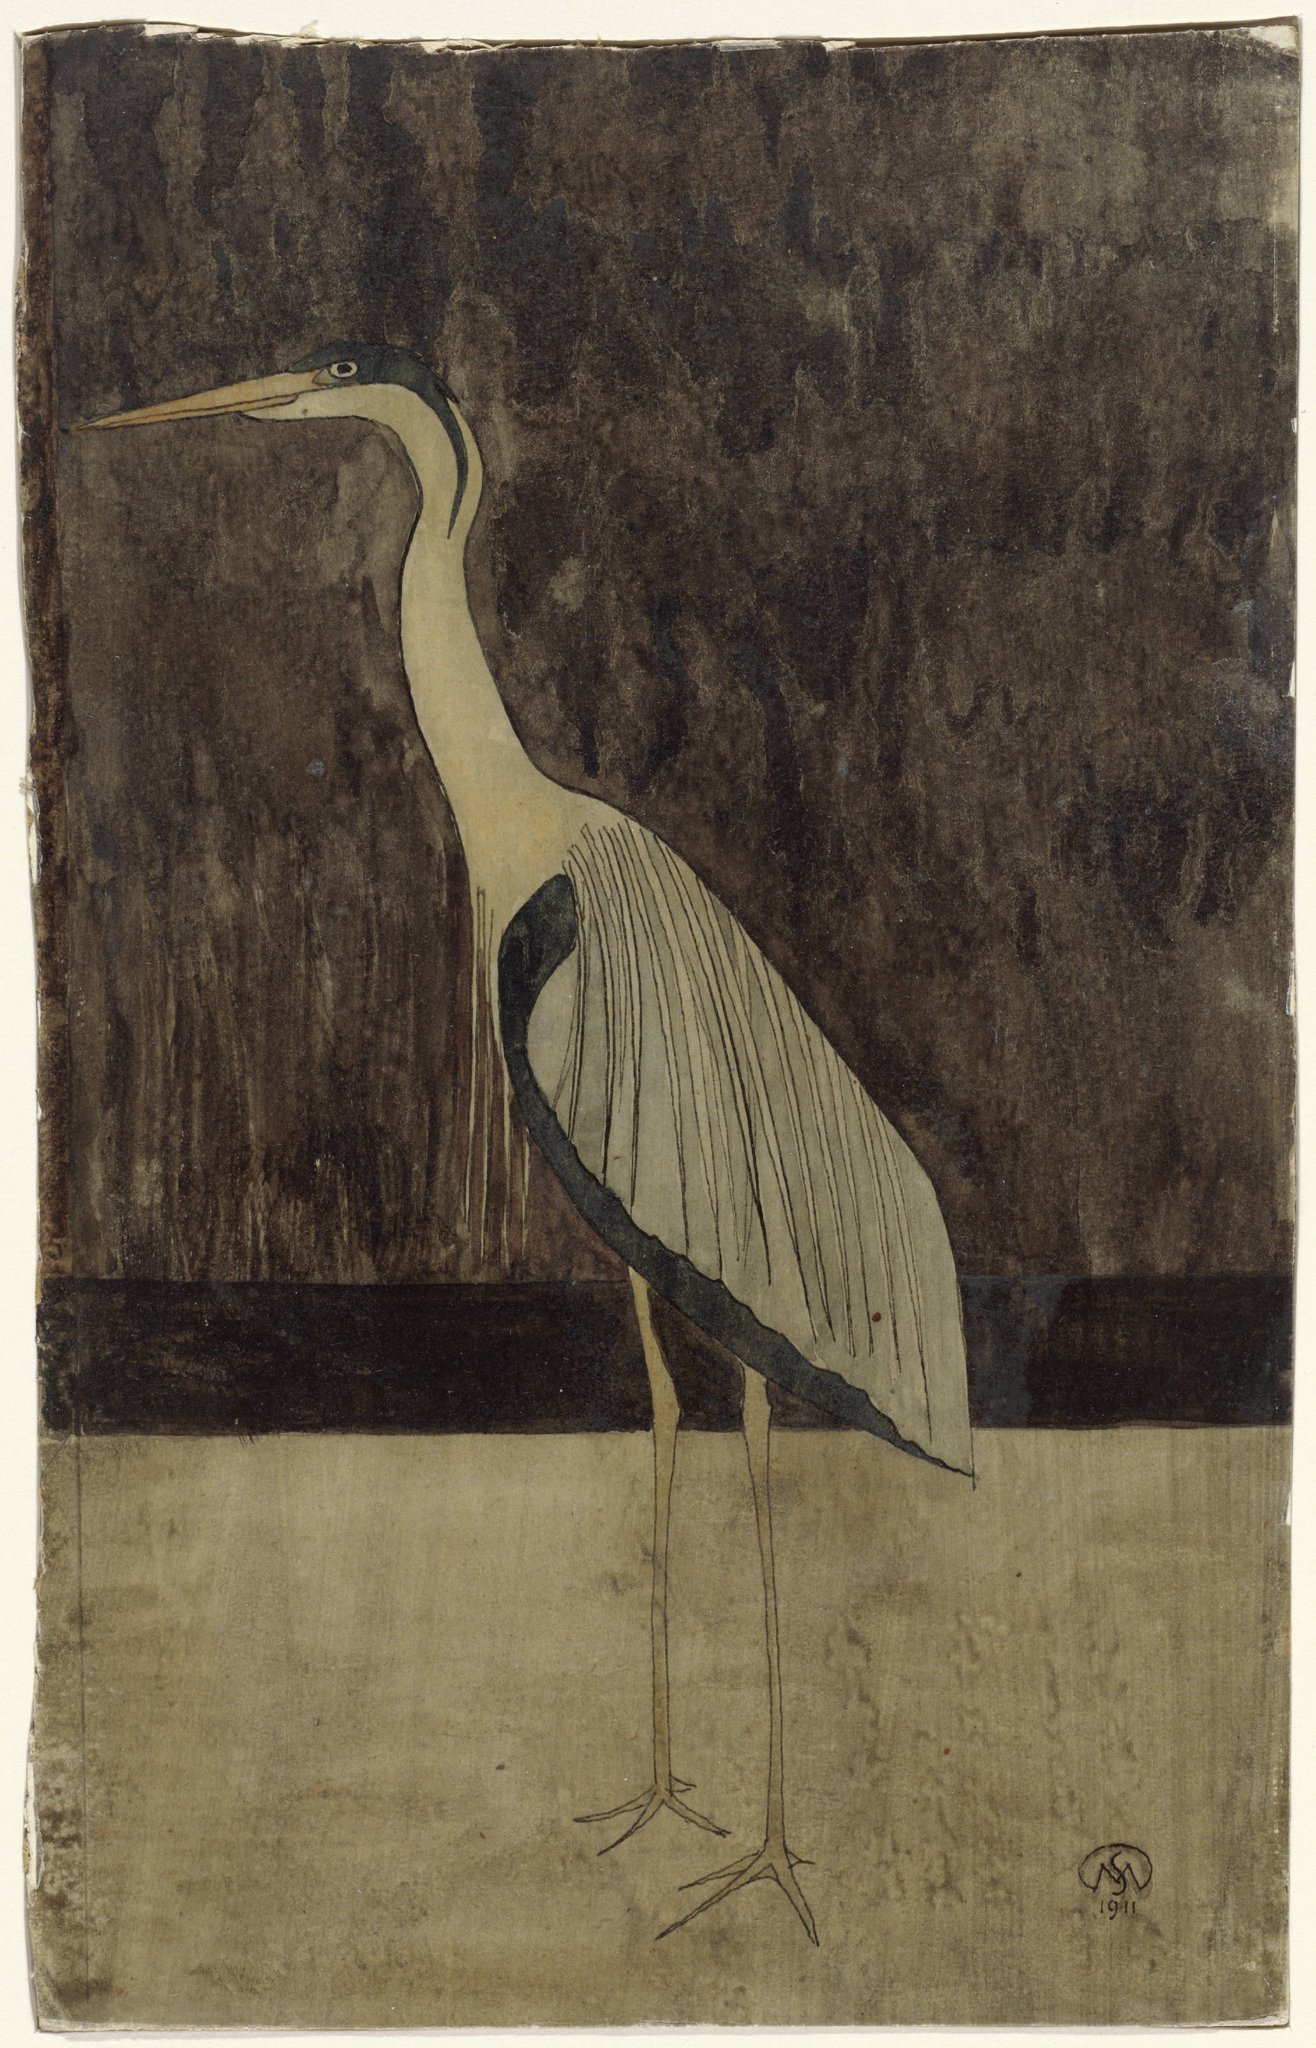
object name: drawing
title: Reiger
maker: samuel jessurun de mesquita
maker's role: draughtsman, print maker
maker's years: 1868-1944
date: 1911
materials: cardboard, ink, paper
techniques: brush, pen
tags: shore-birds and wading-birds: heron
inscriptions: date: ‘1911’